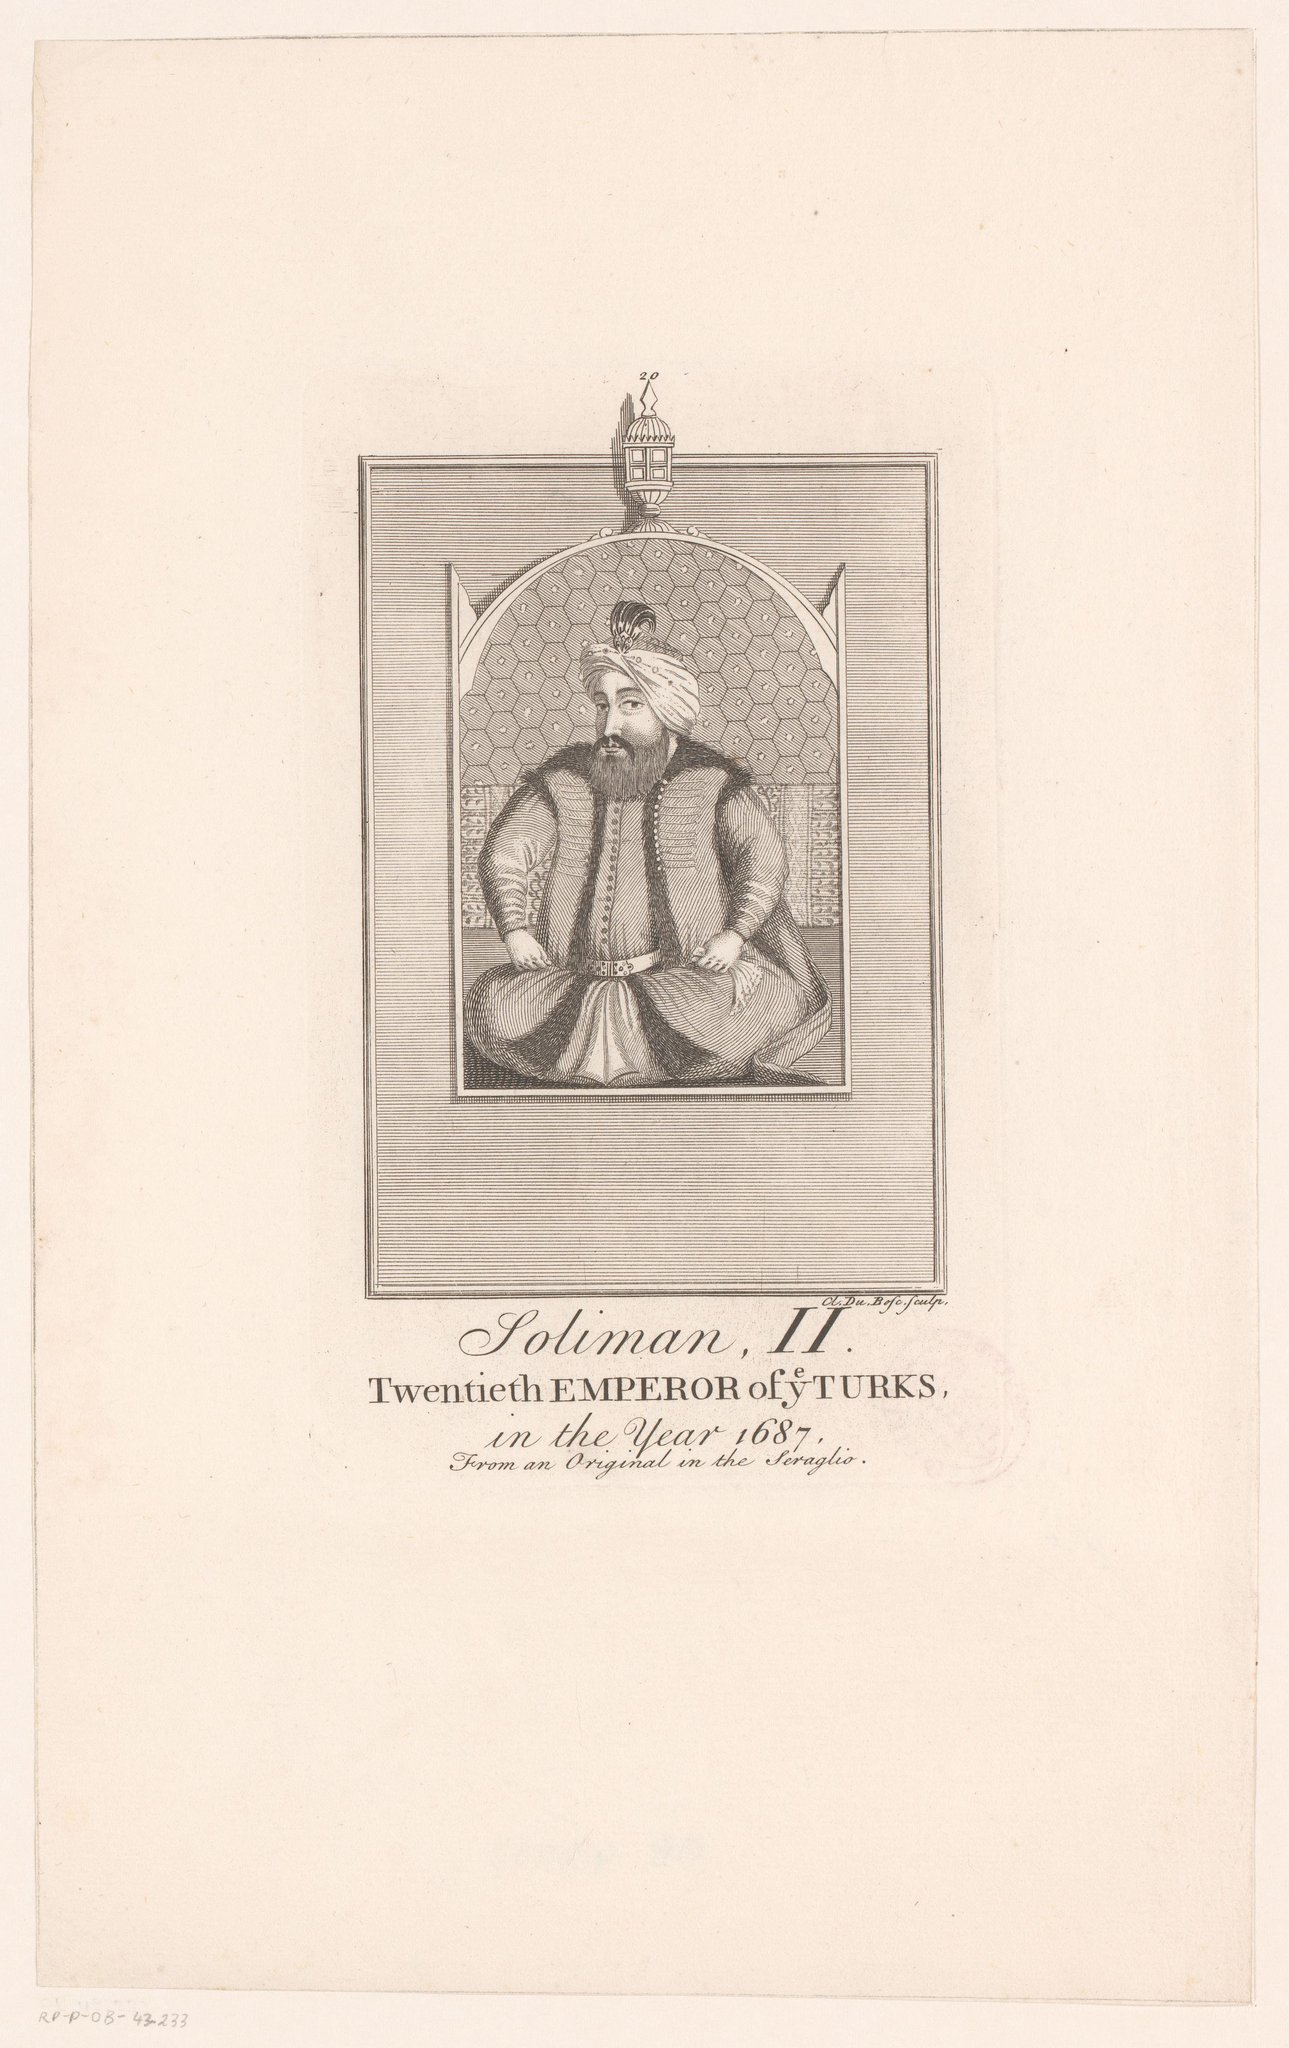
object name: print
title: Portret van Süleyman II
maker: claude dubosc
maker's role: print maker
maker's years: 1682-1745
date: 1692-1745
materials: paper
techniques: engraving, etching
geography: france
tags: historical persons, ruler, sovereign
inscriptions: collector's mark: Lugt 240